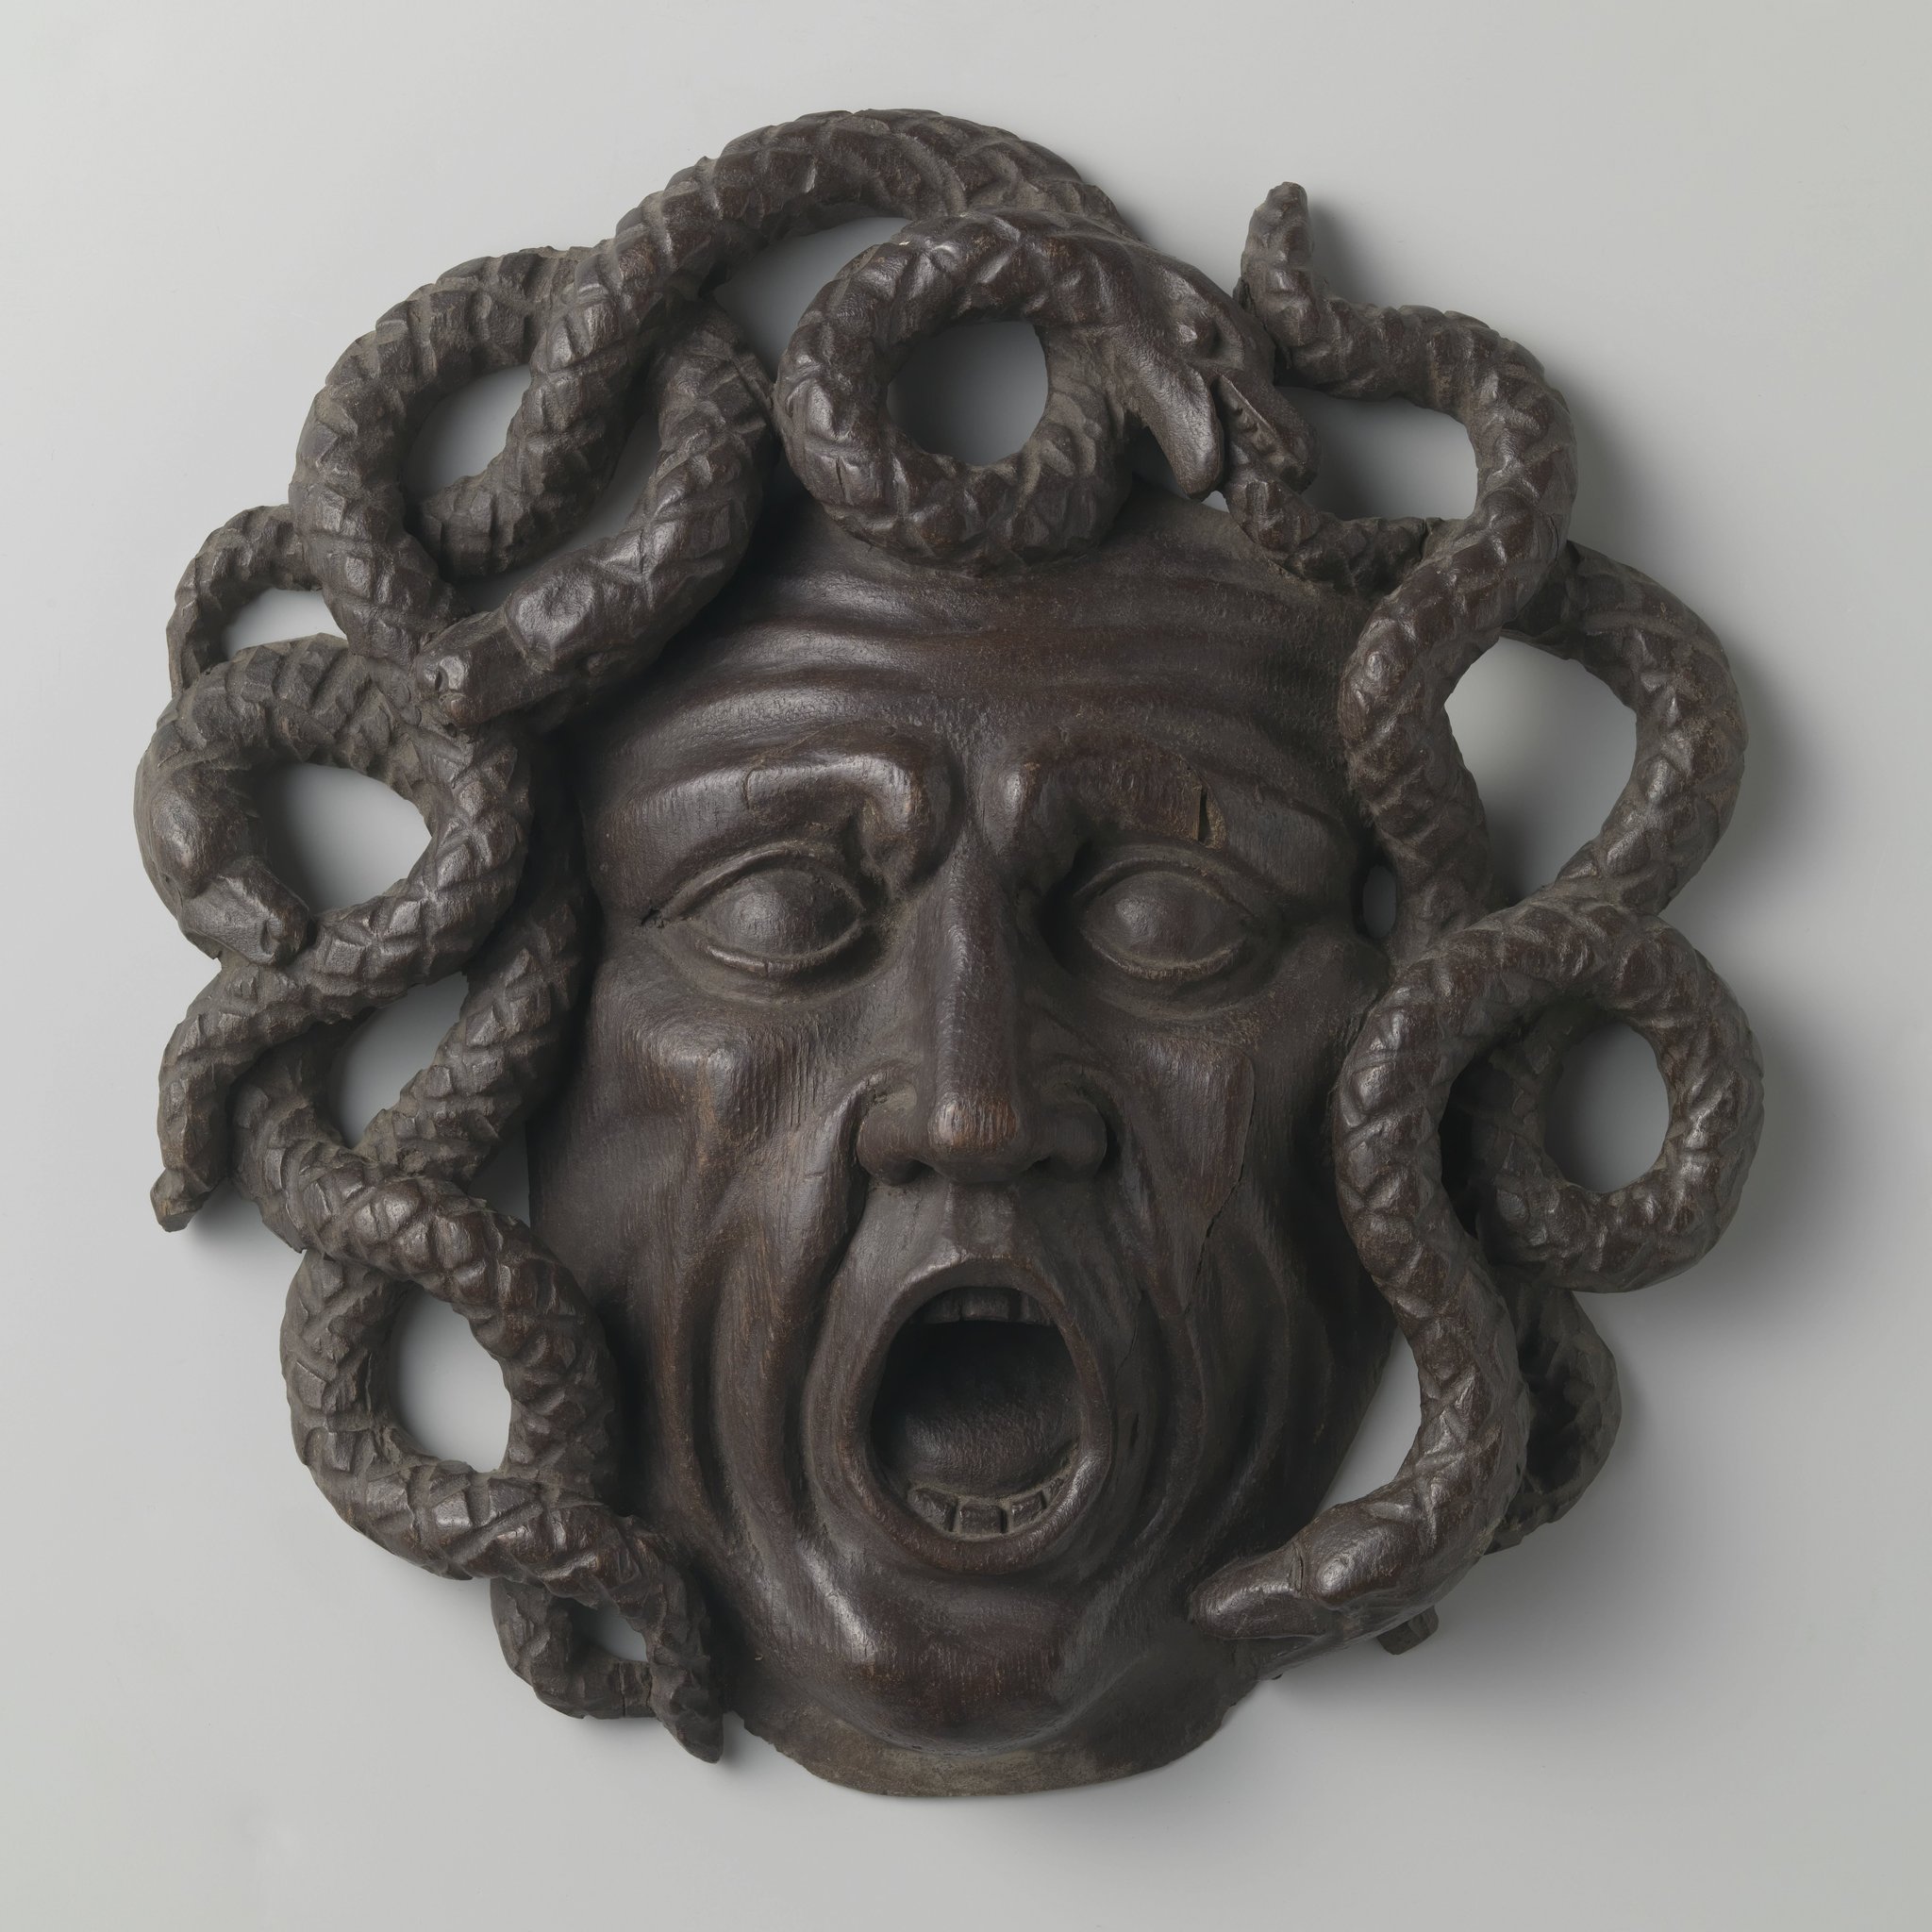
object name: sculpture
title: Medusakop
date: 1600-1699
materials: wood